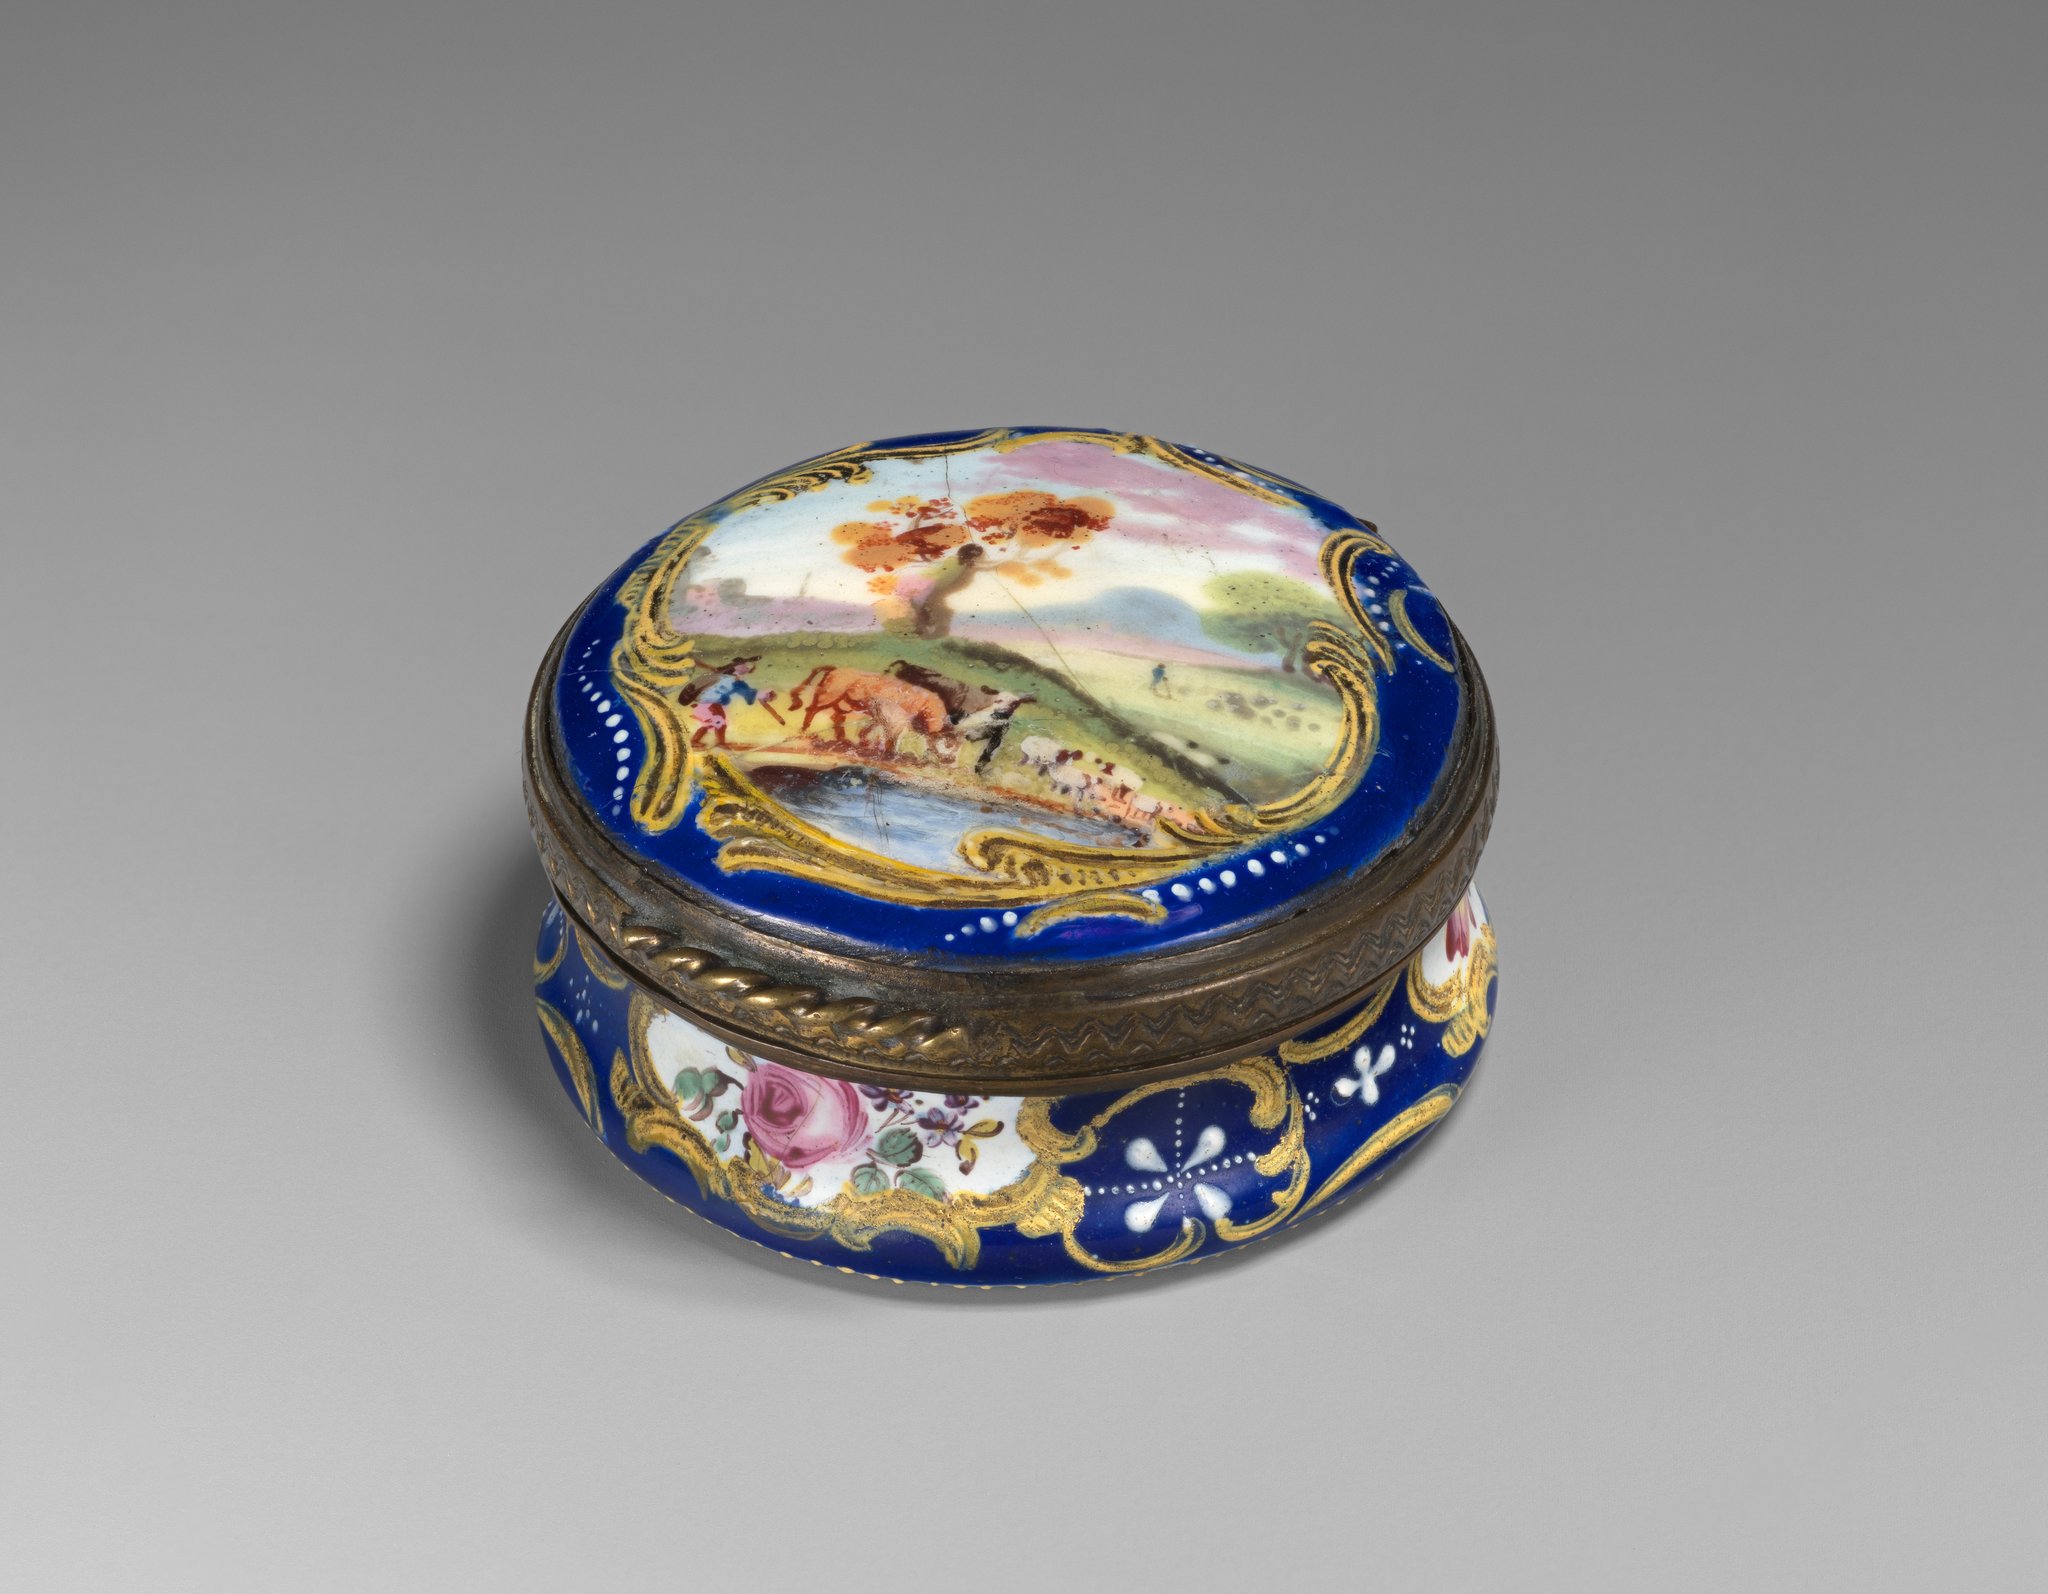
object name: patch box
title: Patch box inscribed “Cent Delices, / pour un Supplice.” [One hundred delights for one torture]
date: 1780-1790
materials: copper, enamel, glass